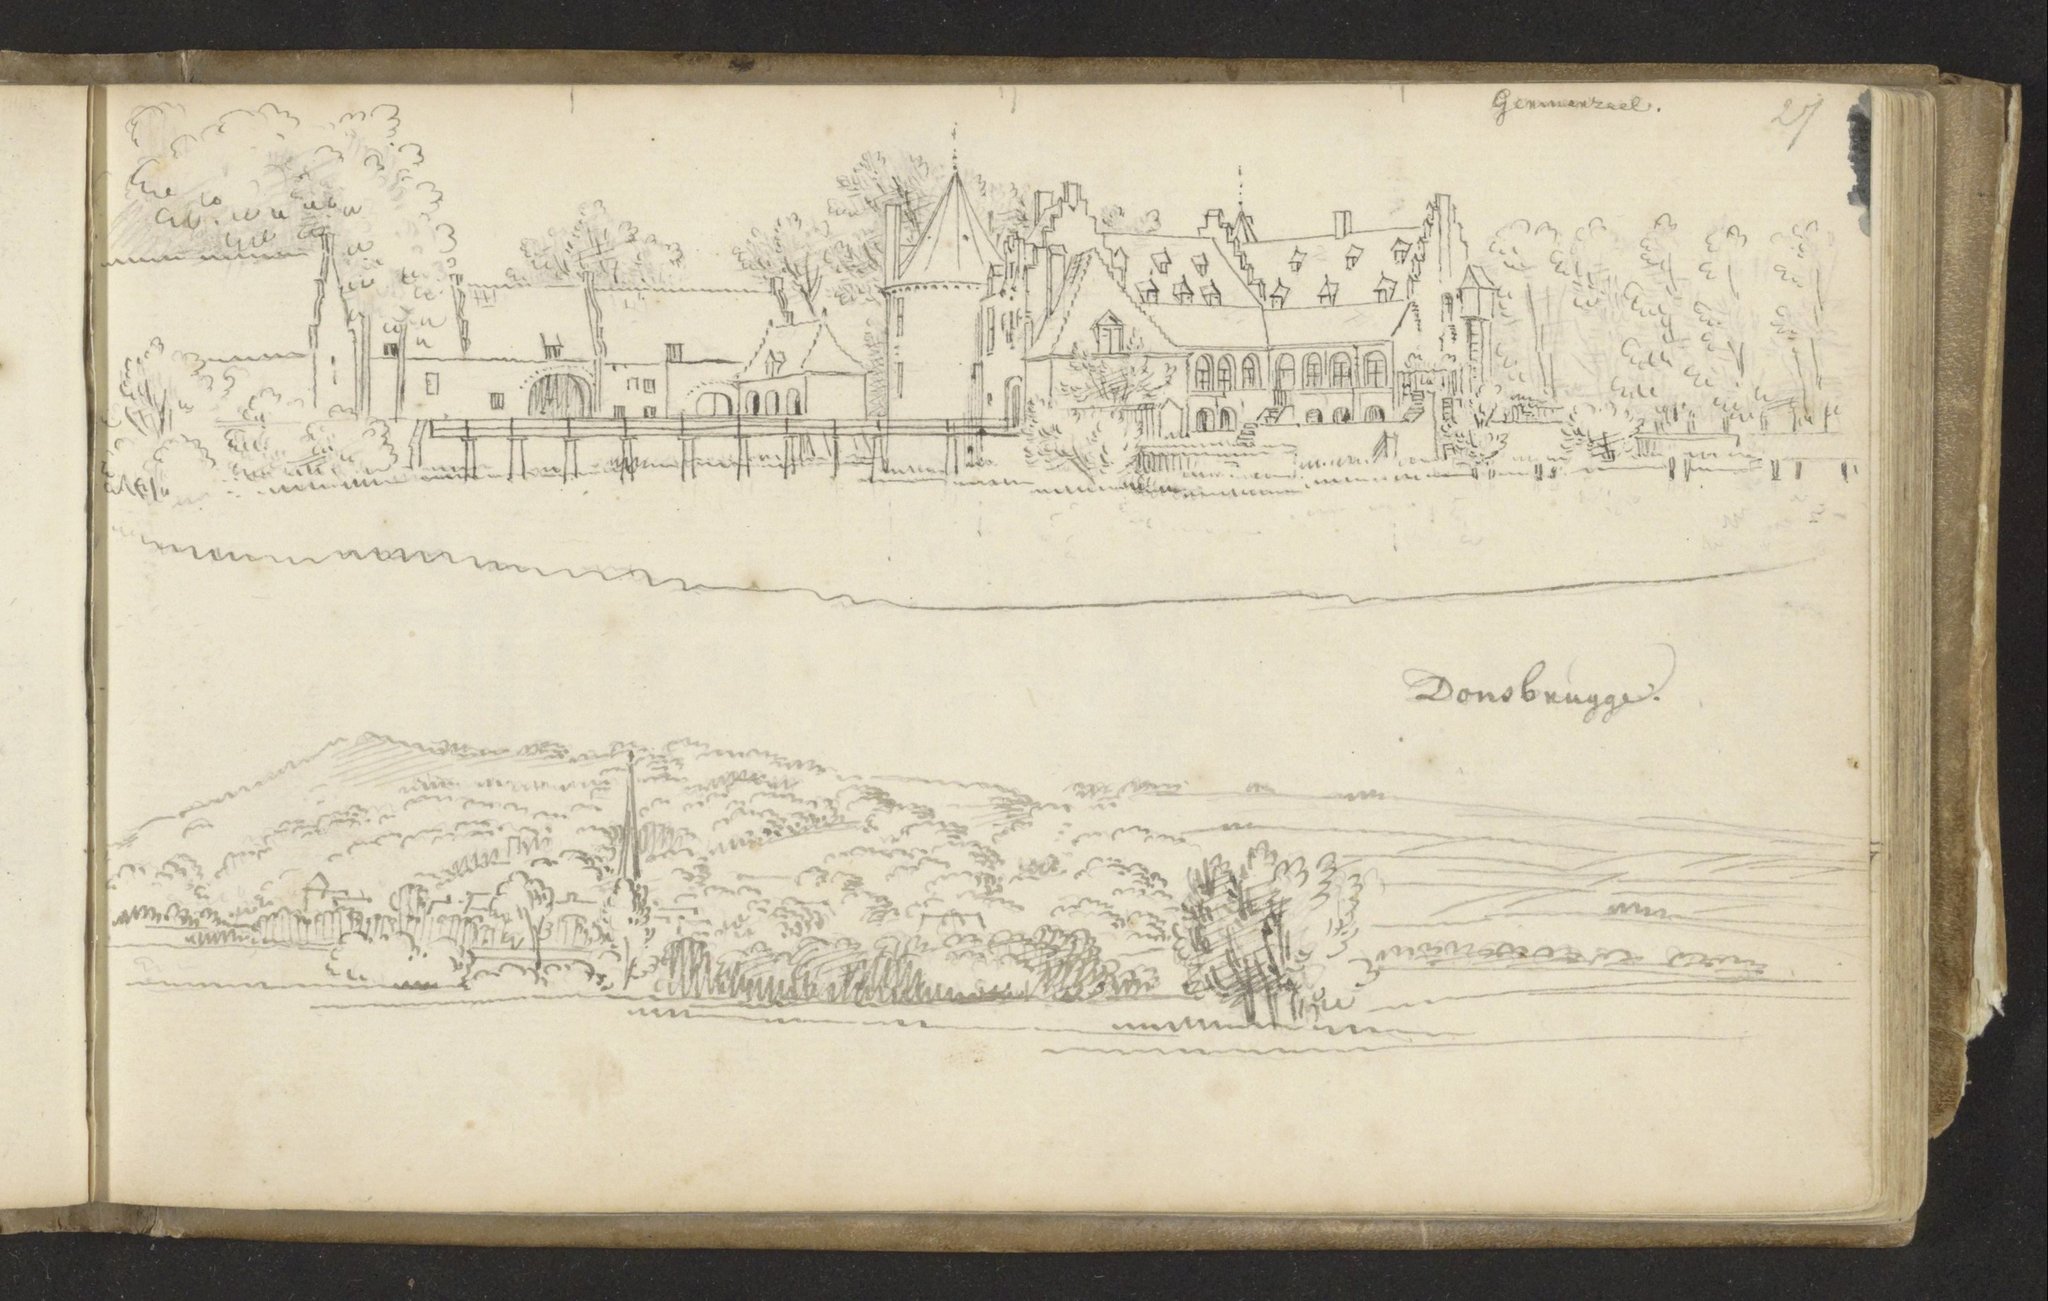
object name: sketchbook leaf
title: Kasteel te Germerzeel en gezichten op Donsbrüggen in Duitsland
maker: abraham de haen (ii)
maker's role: draughtsman, print maker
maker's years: 1707-1748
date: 1731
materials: ink, paper, pencil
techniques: pen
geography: donsbrüggen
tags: prospect of village, silhouette of village, castle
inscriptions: annotation: ‘Germerzeel/ Donsbrugge’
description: Blad 27 recto uit een schetsboek met 69 bladen.